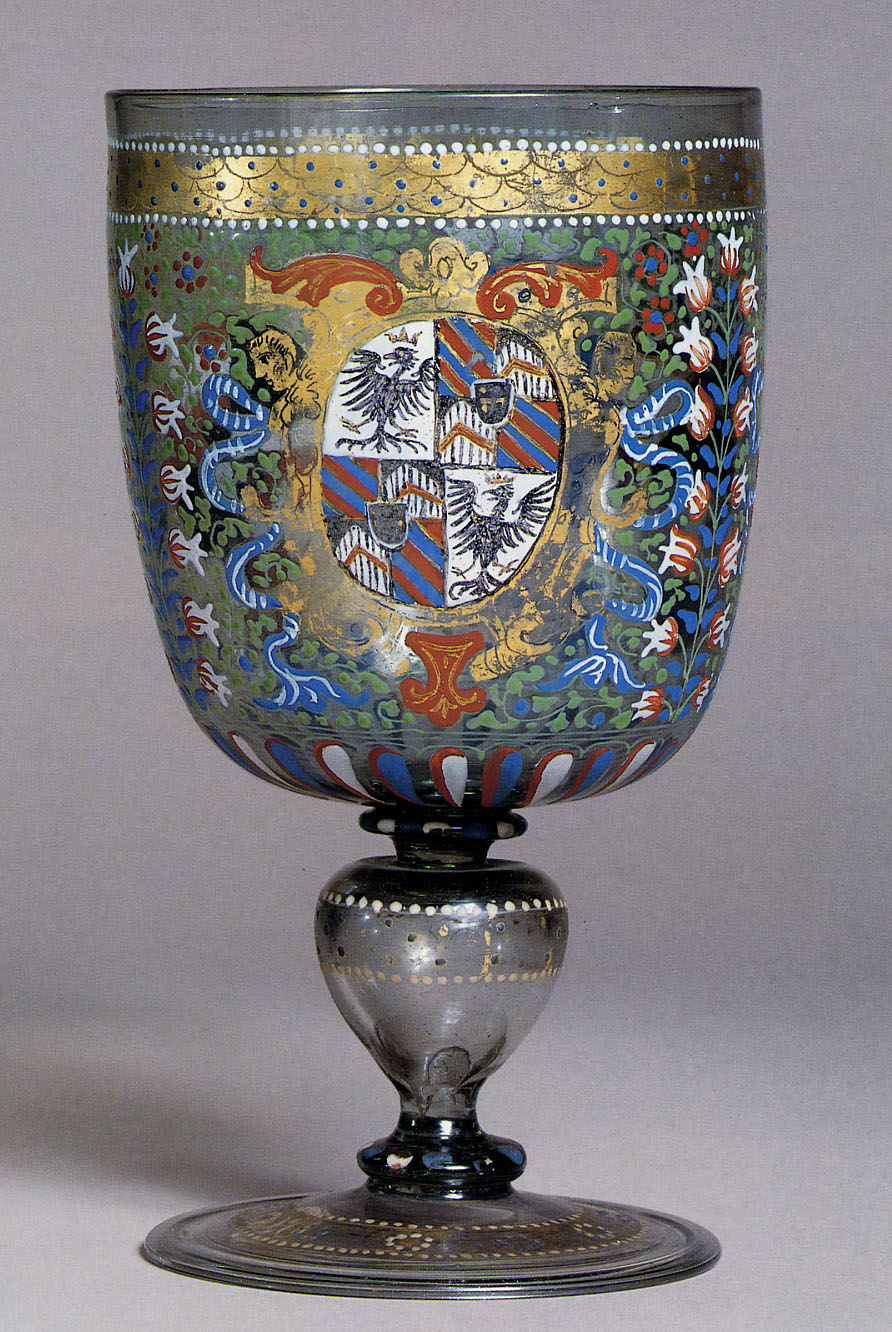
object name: goblet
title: Armorial goblet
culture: façon de venise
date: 1592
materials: gilt, glass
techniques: glassblowing, enamel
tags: coat of arms